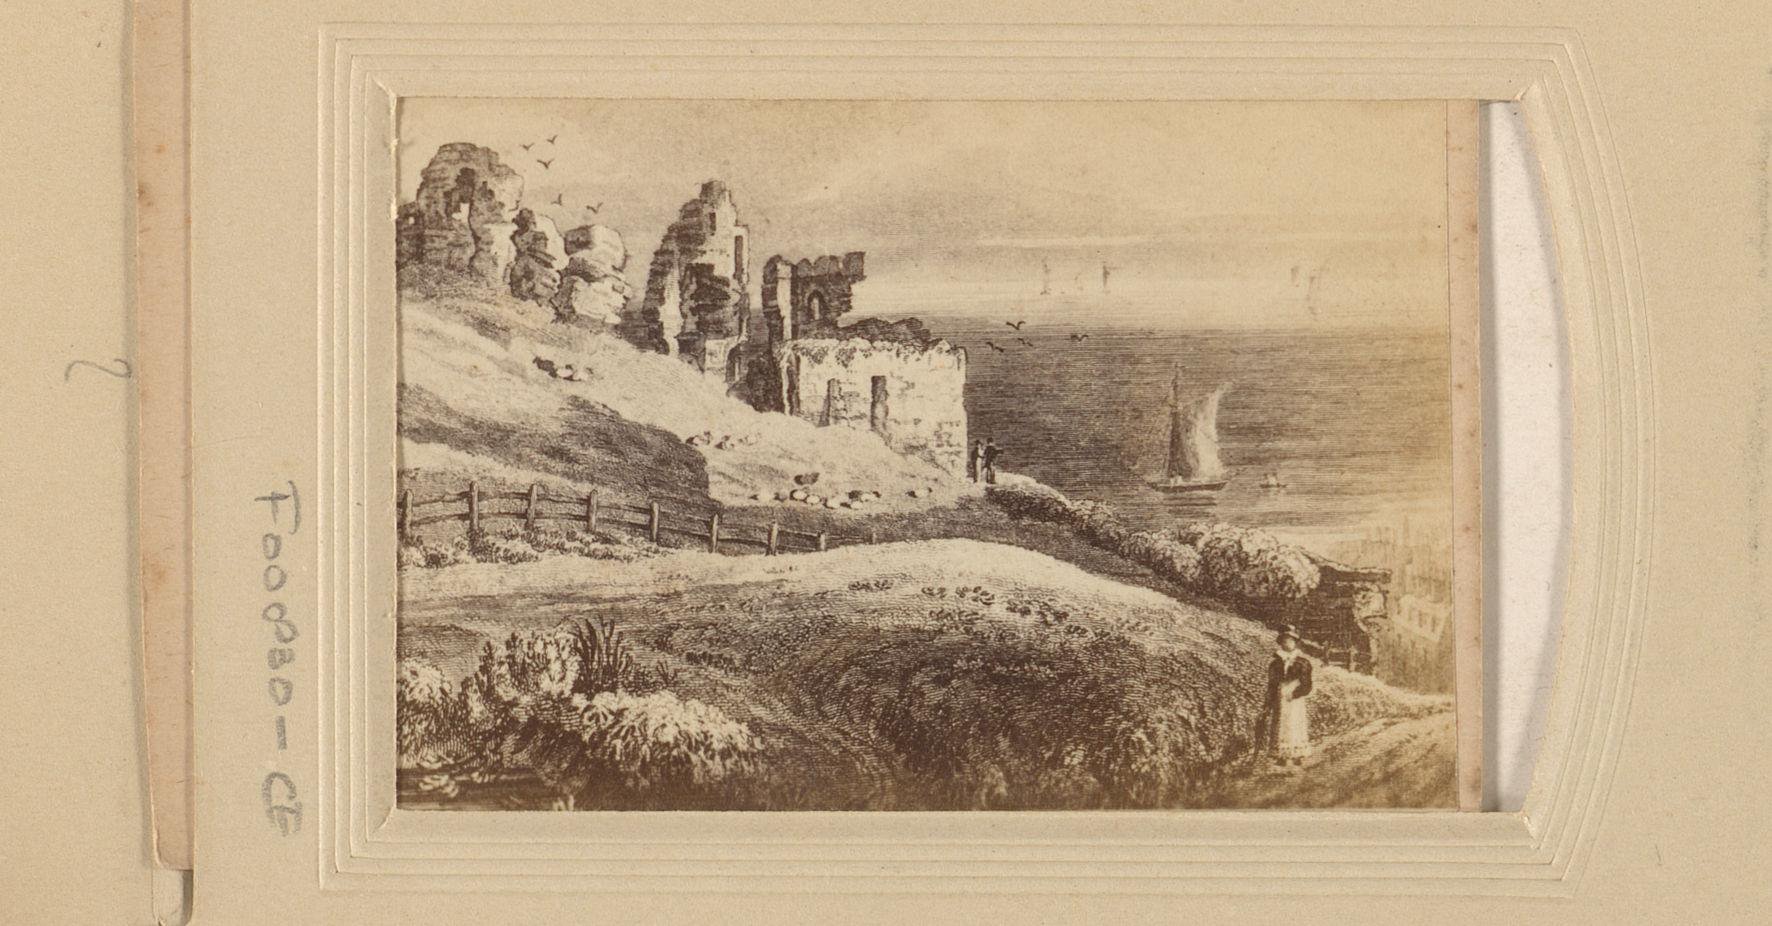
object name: photograph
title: Fotoreproductie van prent van landschap met ruïnes aan zee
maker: Anonymous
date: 1870-1900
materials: cardboard, photographic support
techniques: albumen print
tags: the graphic arts, landscape with ruins, sea (seascape)